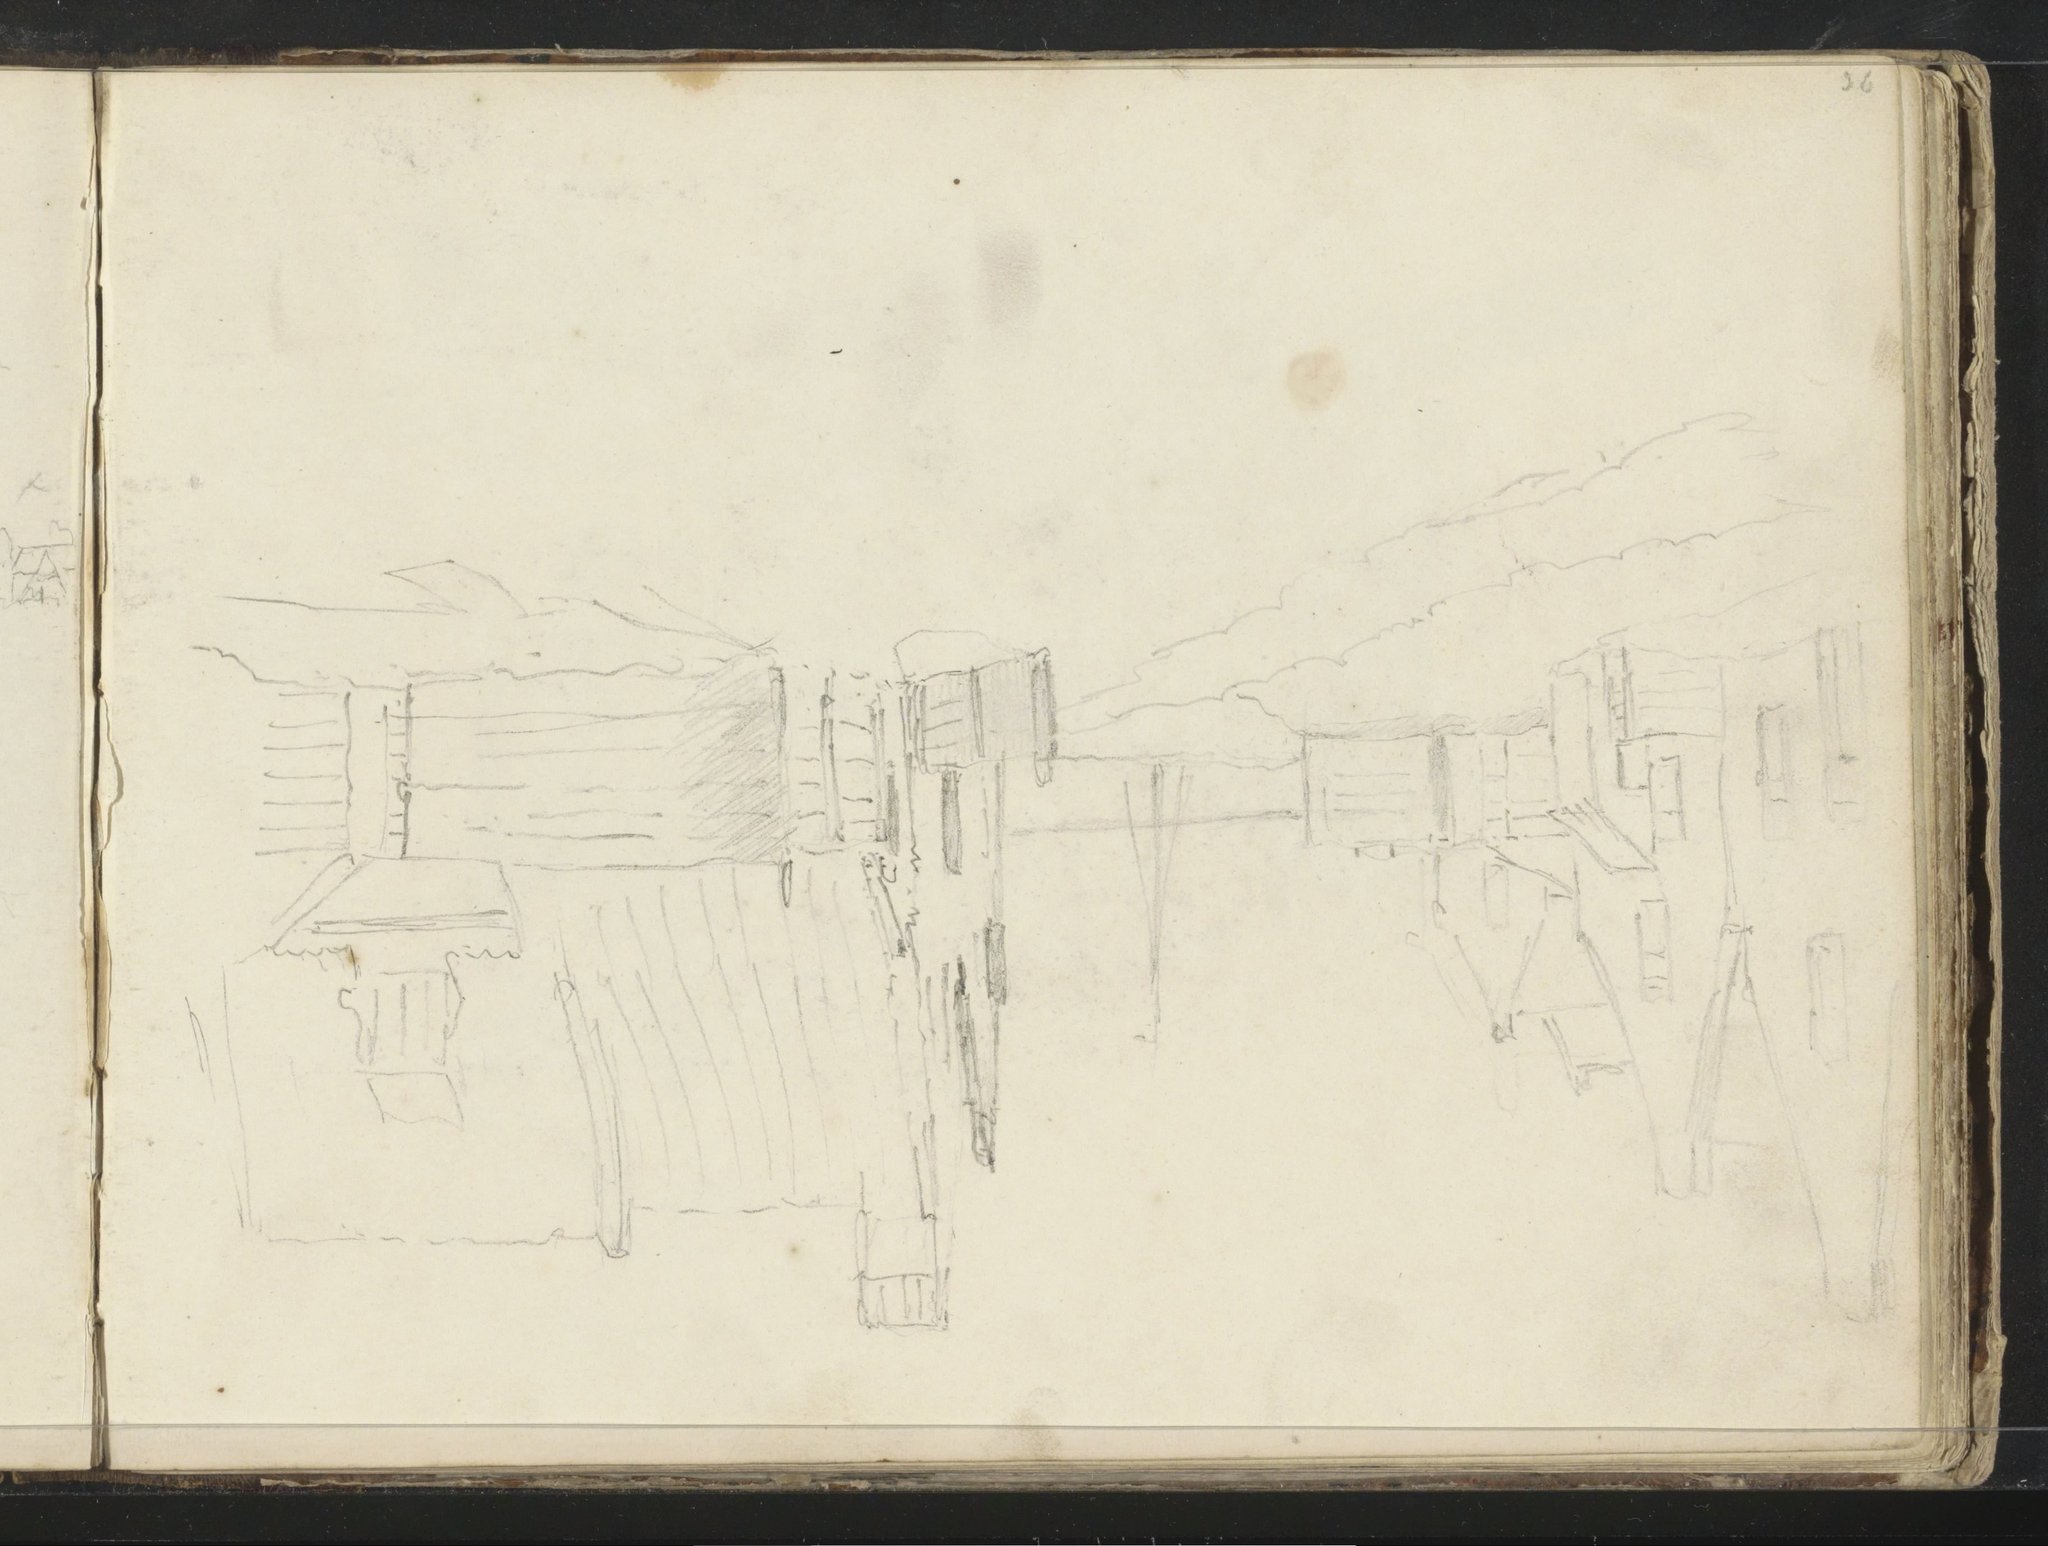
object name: sketchbook leaf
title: Dorpsstraat uitkomend op een kade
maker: willem troost (ii)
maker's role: draughtsman, painter, print maker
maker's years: 1812-1893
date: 1822-1893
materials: paper, pencil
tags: village street, pier, quay, wharf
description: Blad 36 recto uit een schetsboek met 36 bladen.